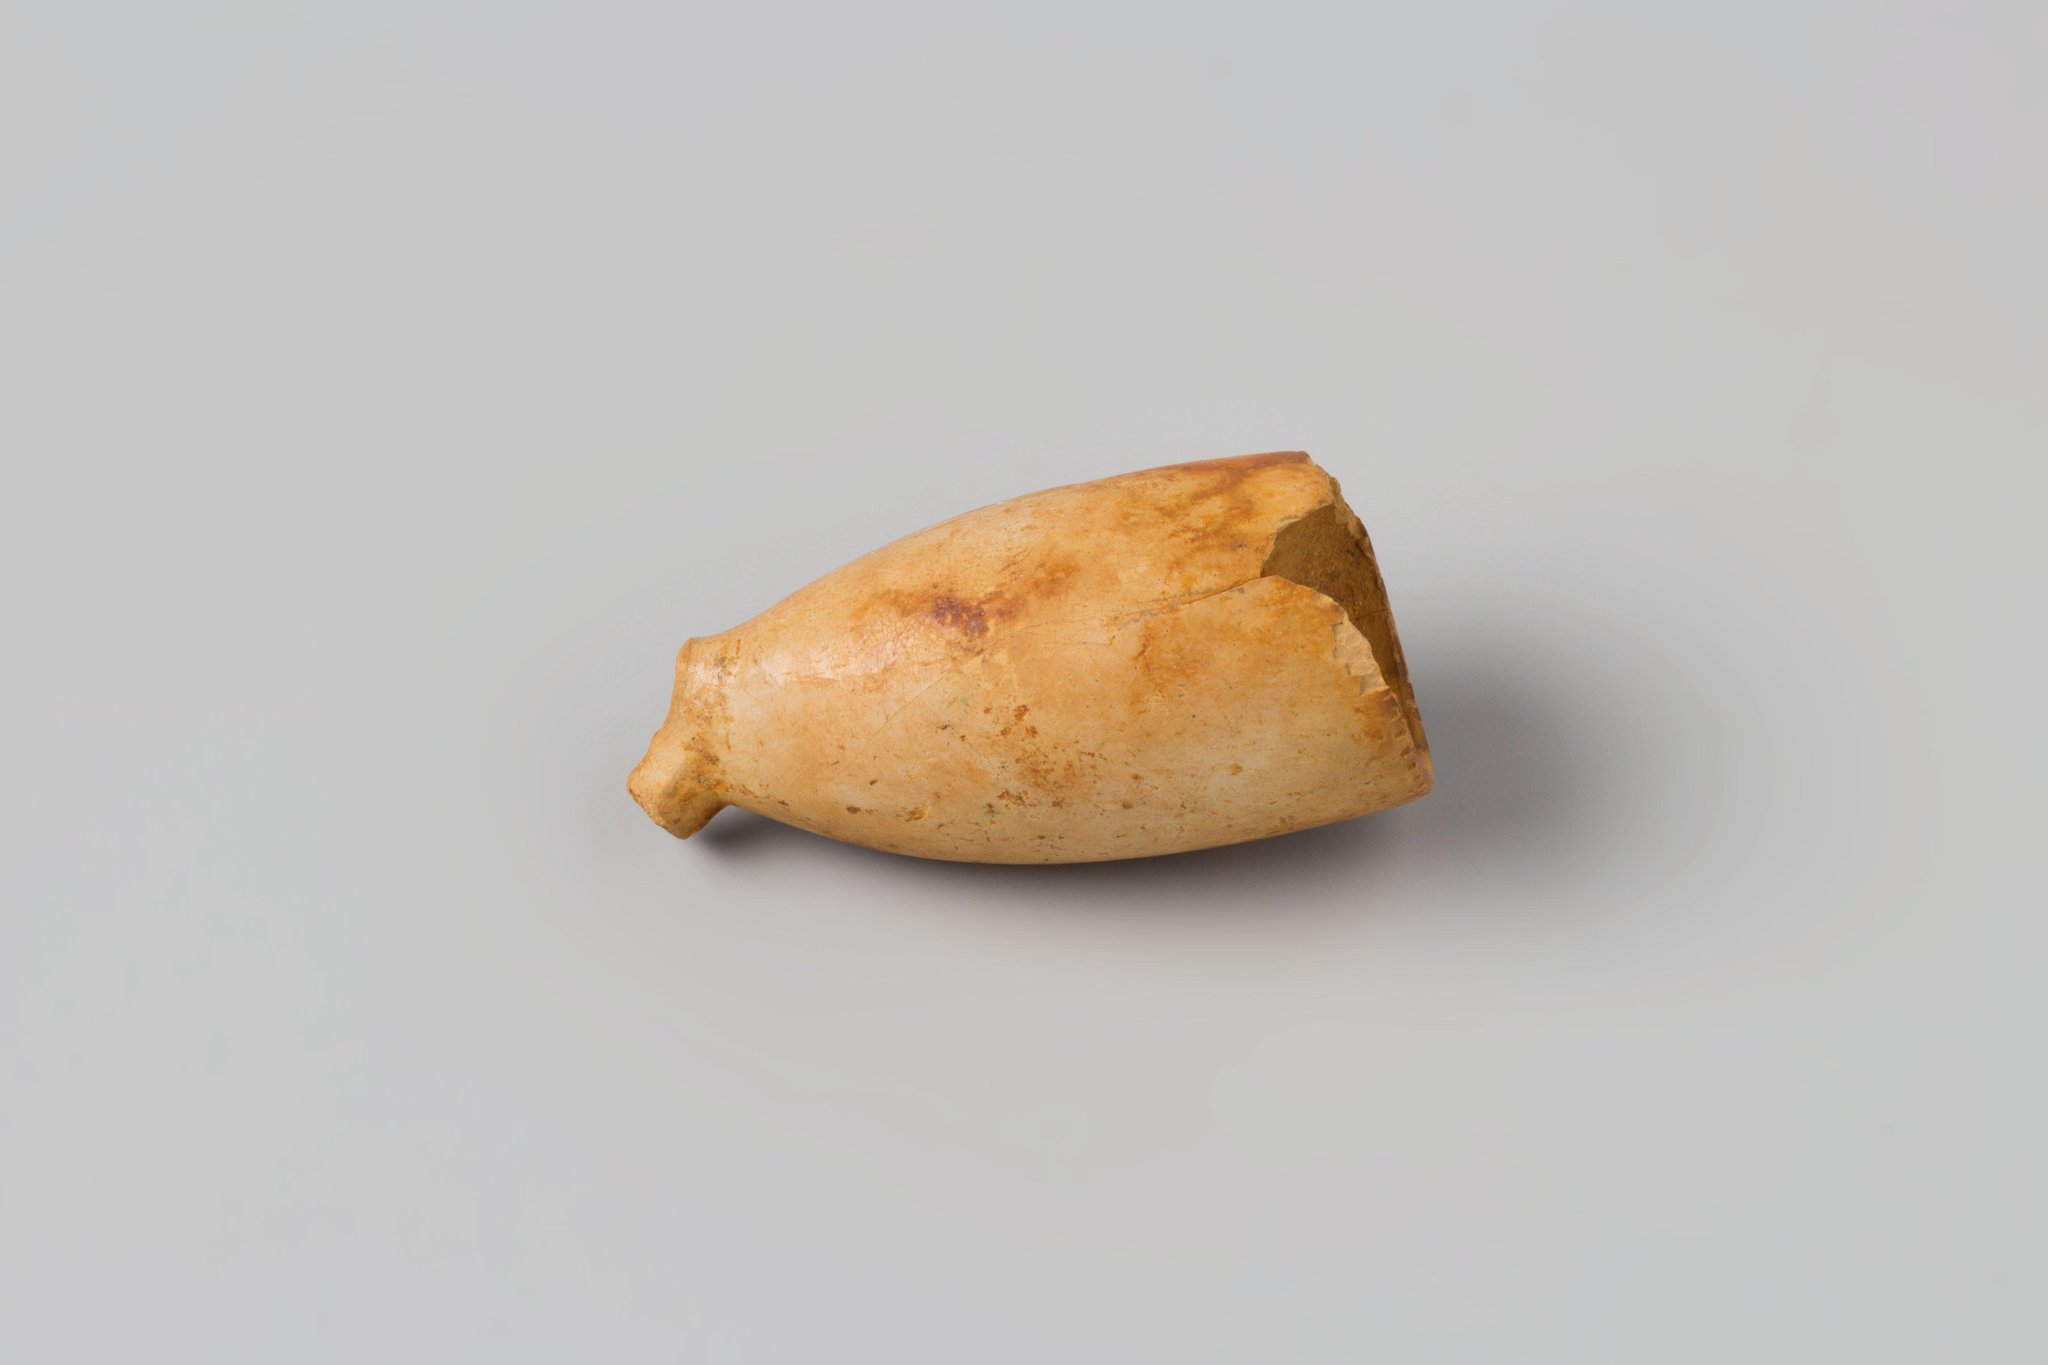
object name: pipe bowl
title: Pijpenkop uit het wrak van de Oost-Indiëvaarder Hollandia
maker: Anonymous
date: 1700-1743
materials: clay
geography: netherlands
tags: verenigde oostindische compagnie, hollandia (schip), annet